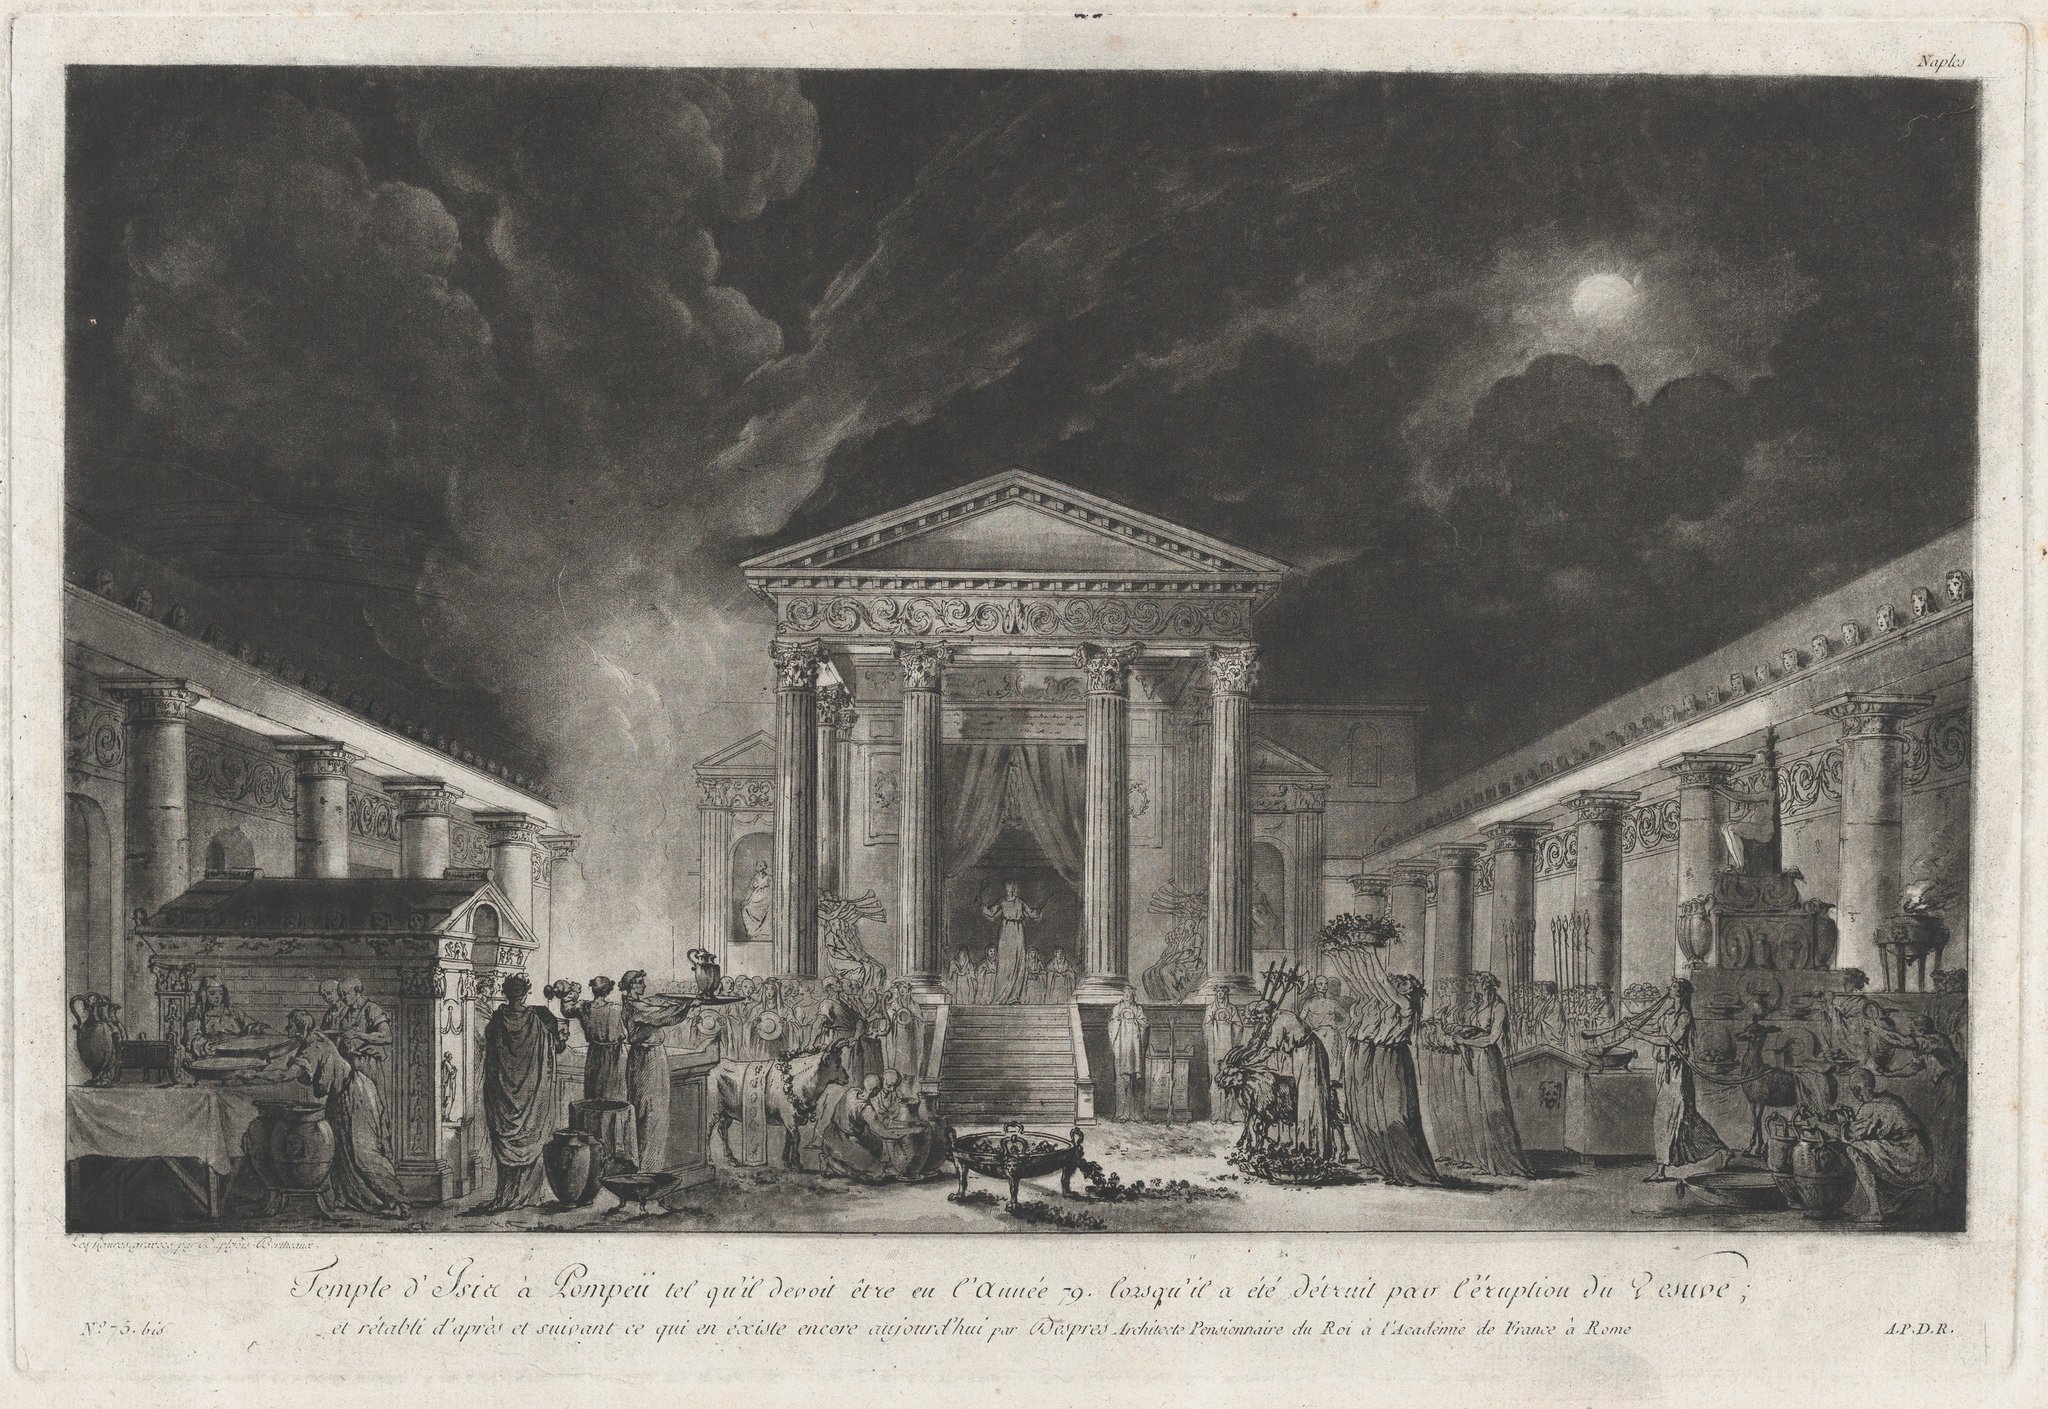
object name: print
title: Temple of Isis at Pompeii, from "Voyage pittoresque de Naples et de Sicile"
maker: edouard gautier-dagoty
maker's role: etcher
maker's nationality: french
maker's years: 1745-1783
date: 1781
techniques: aquatint, etching